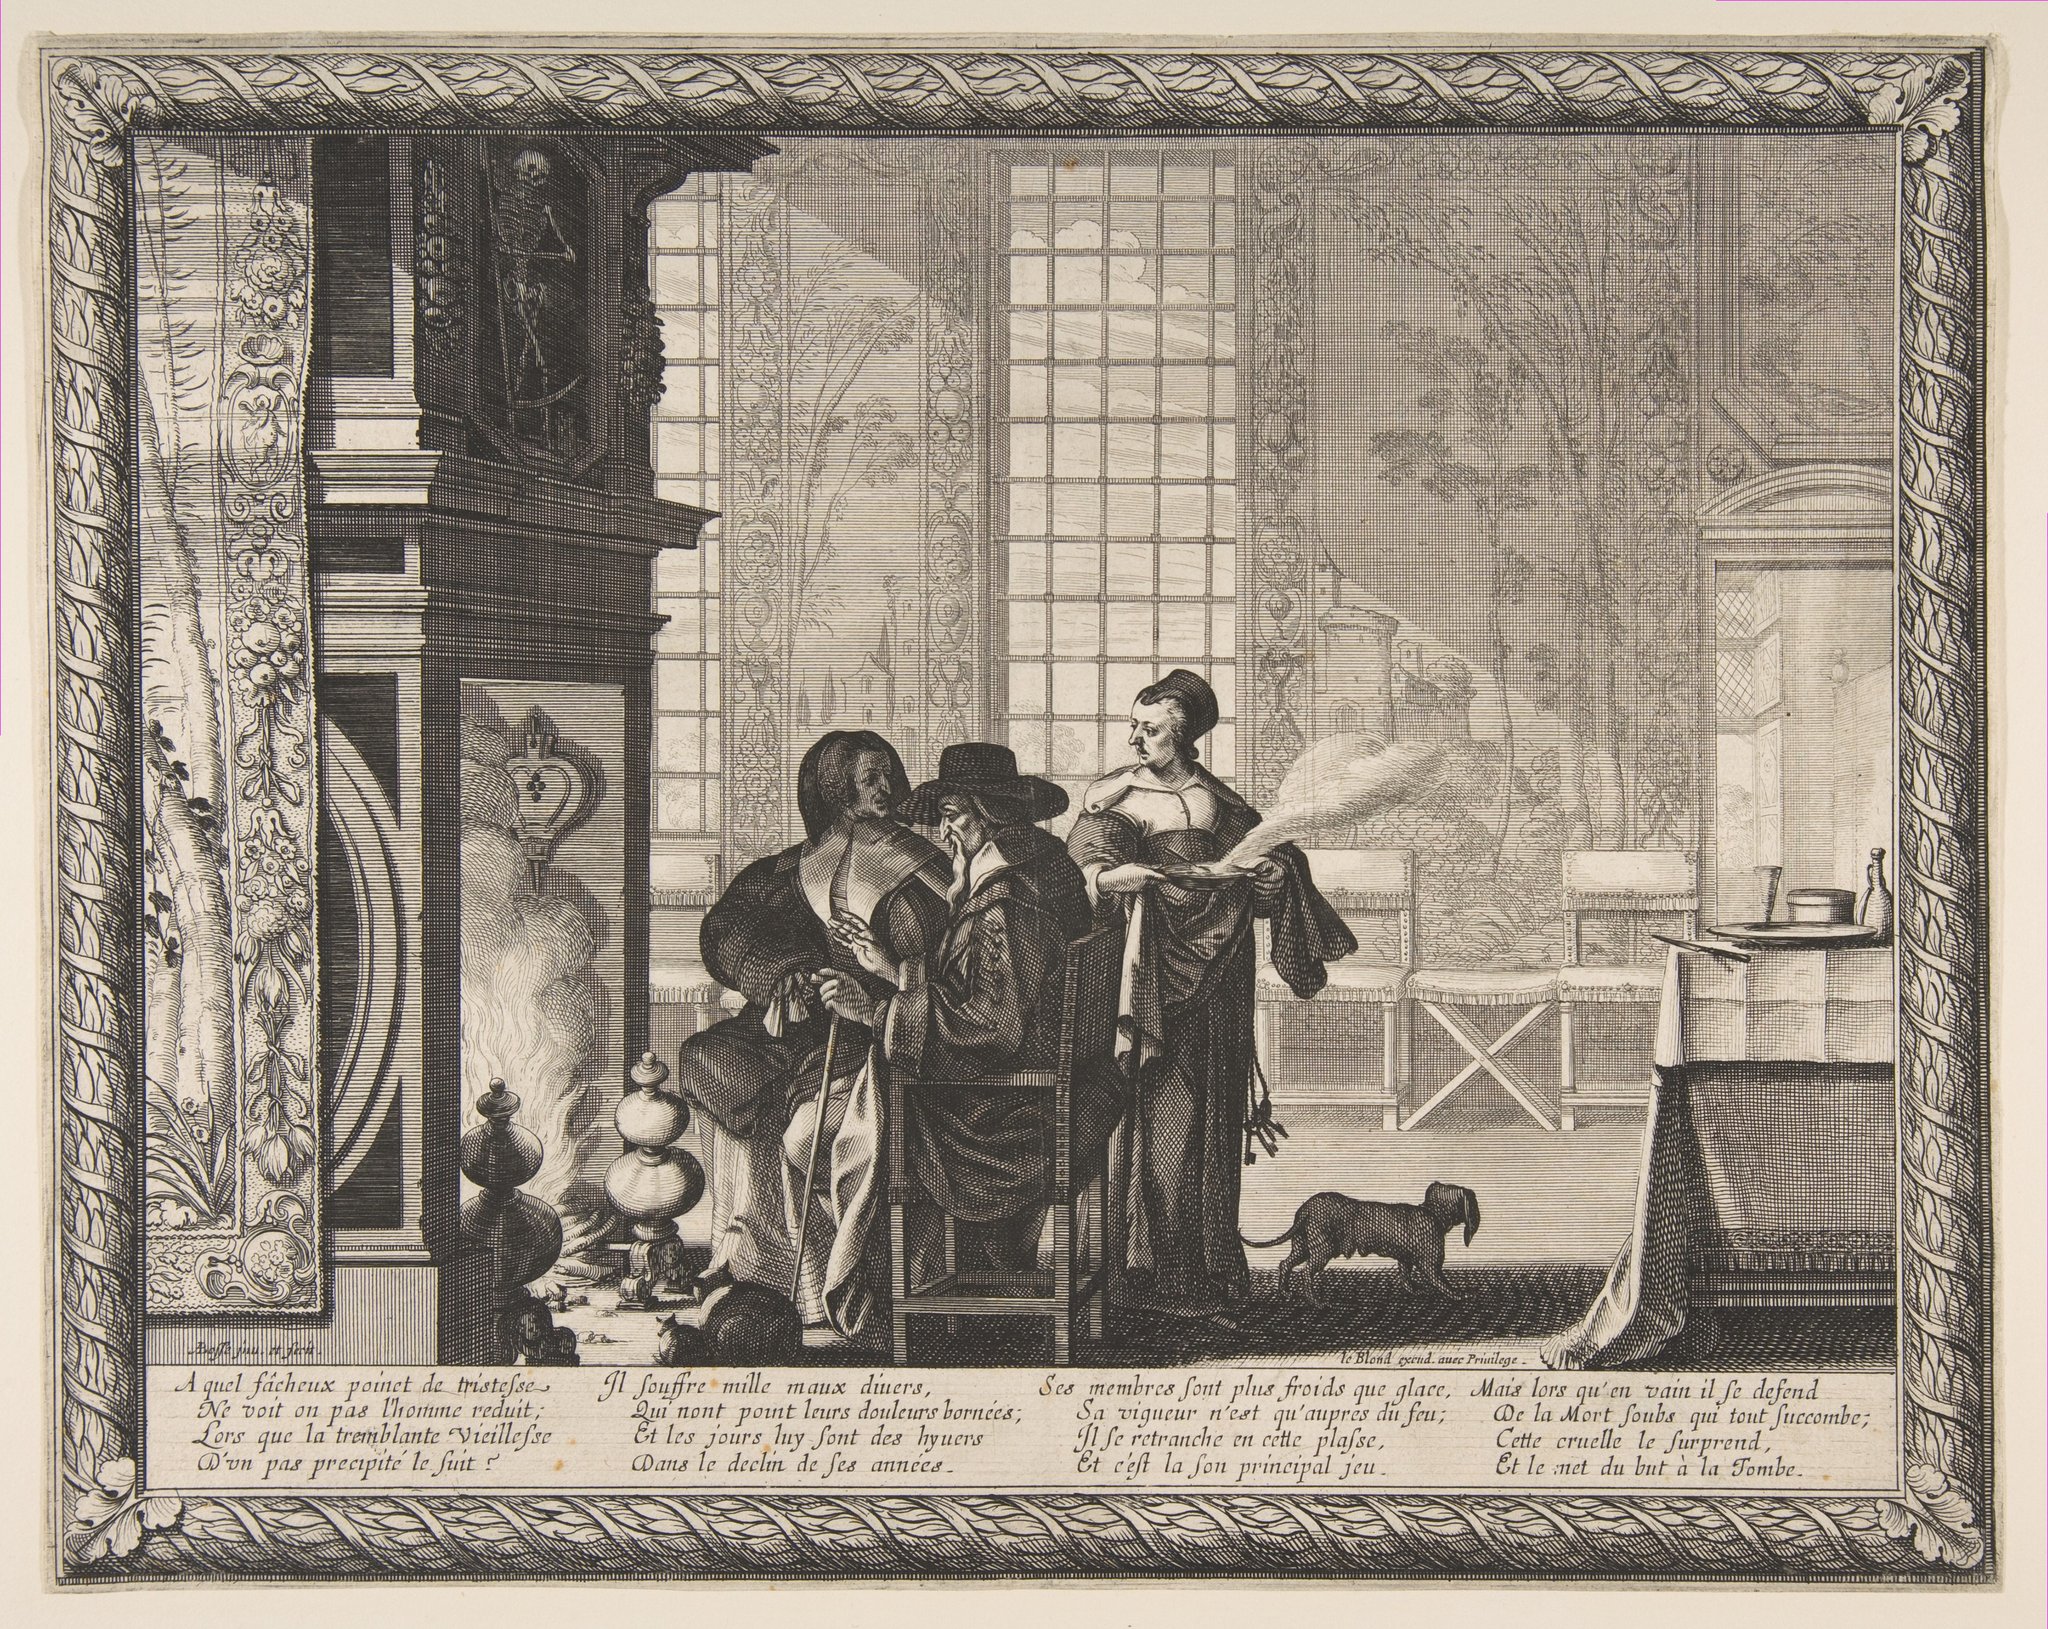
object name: print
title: Old Age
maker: abraham bosse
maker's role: artist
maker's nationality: french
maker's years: 1602-1676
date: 1636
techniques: engraving, etching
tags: men,women